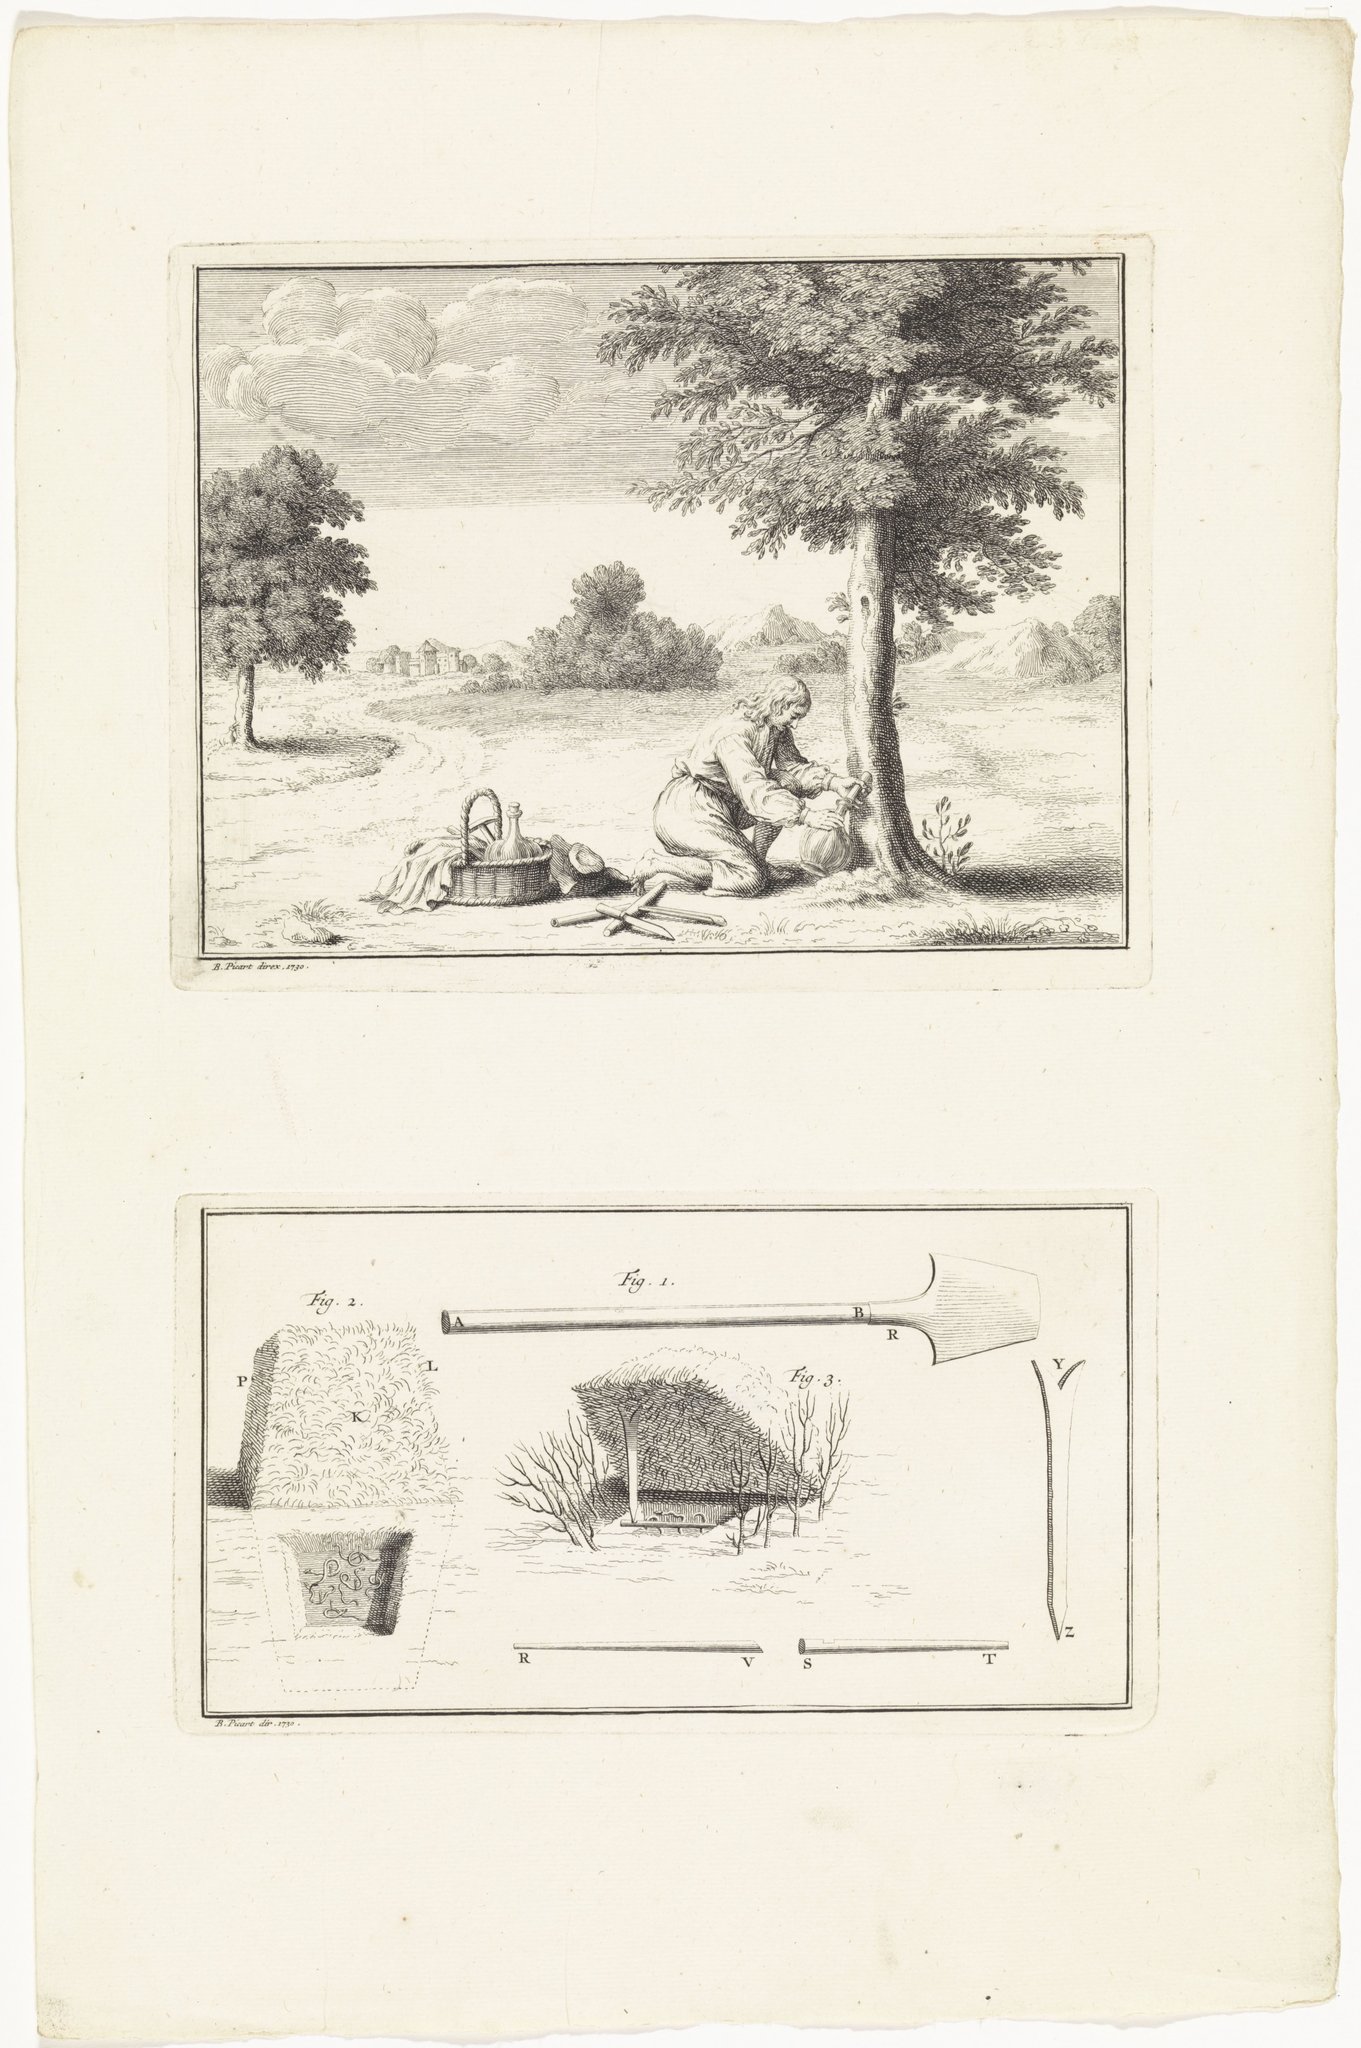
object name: print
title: Tappen van vocht uit een boom en manieren om wormen te vangen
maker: bernard picart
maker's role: draughtsman, print maker, publisher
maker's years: 1673-1733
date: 1730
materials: paper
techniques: engraving, etching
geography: amsterdam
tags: spading ~ soil cultivation, agriculture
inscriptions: collector's mark: Lugt 2233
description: Prenten bedoeld voor: Chomel, Noel. Dictionnaire oeconomique, contenant divers moïens d'augmenter son bien, et de conserver sa santé. Amsterdam: Johannes Covens en Cornelis Mortier, 1732.